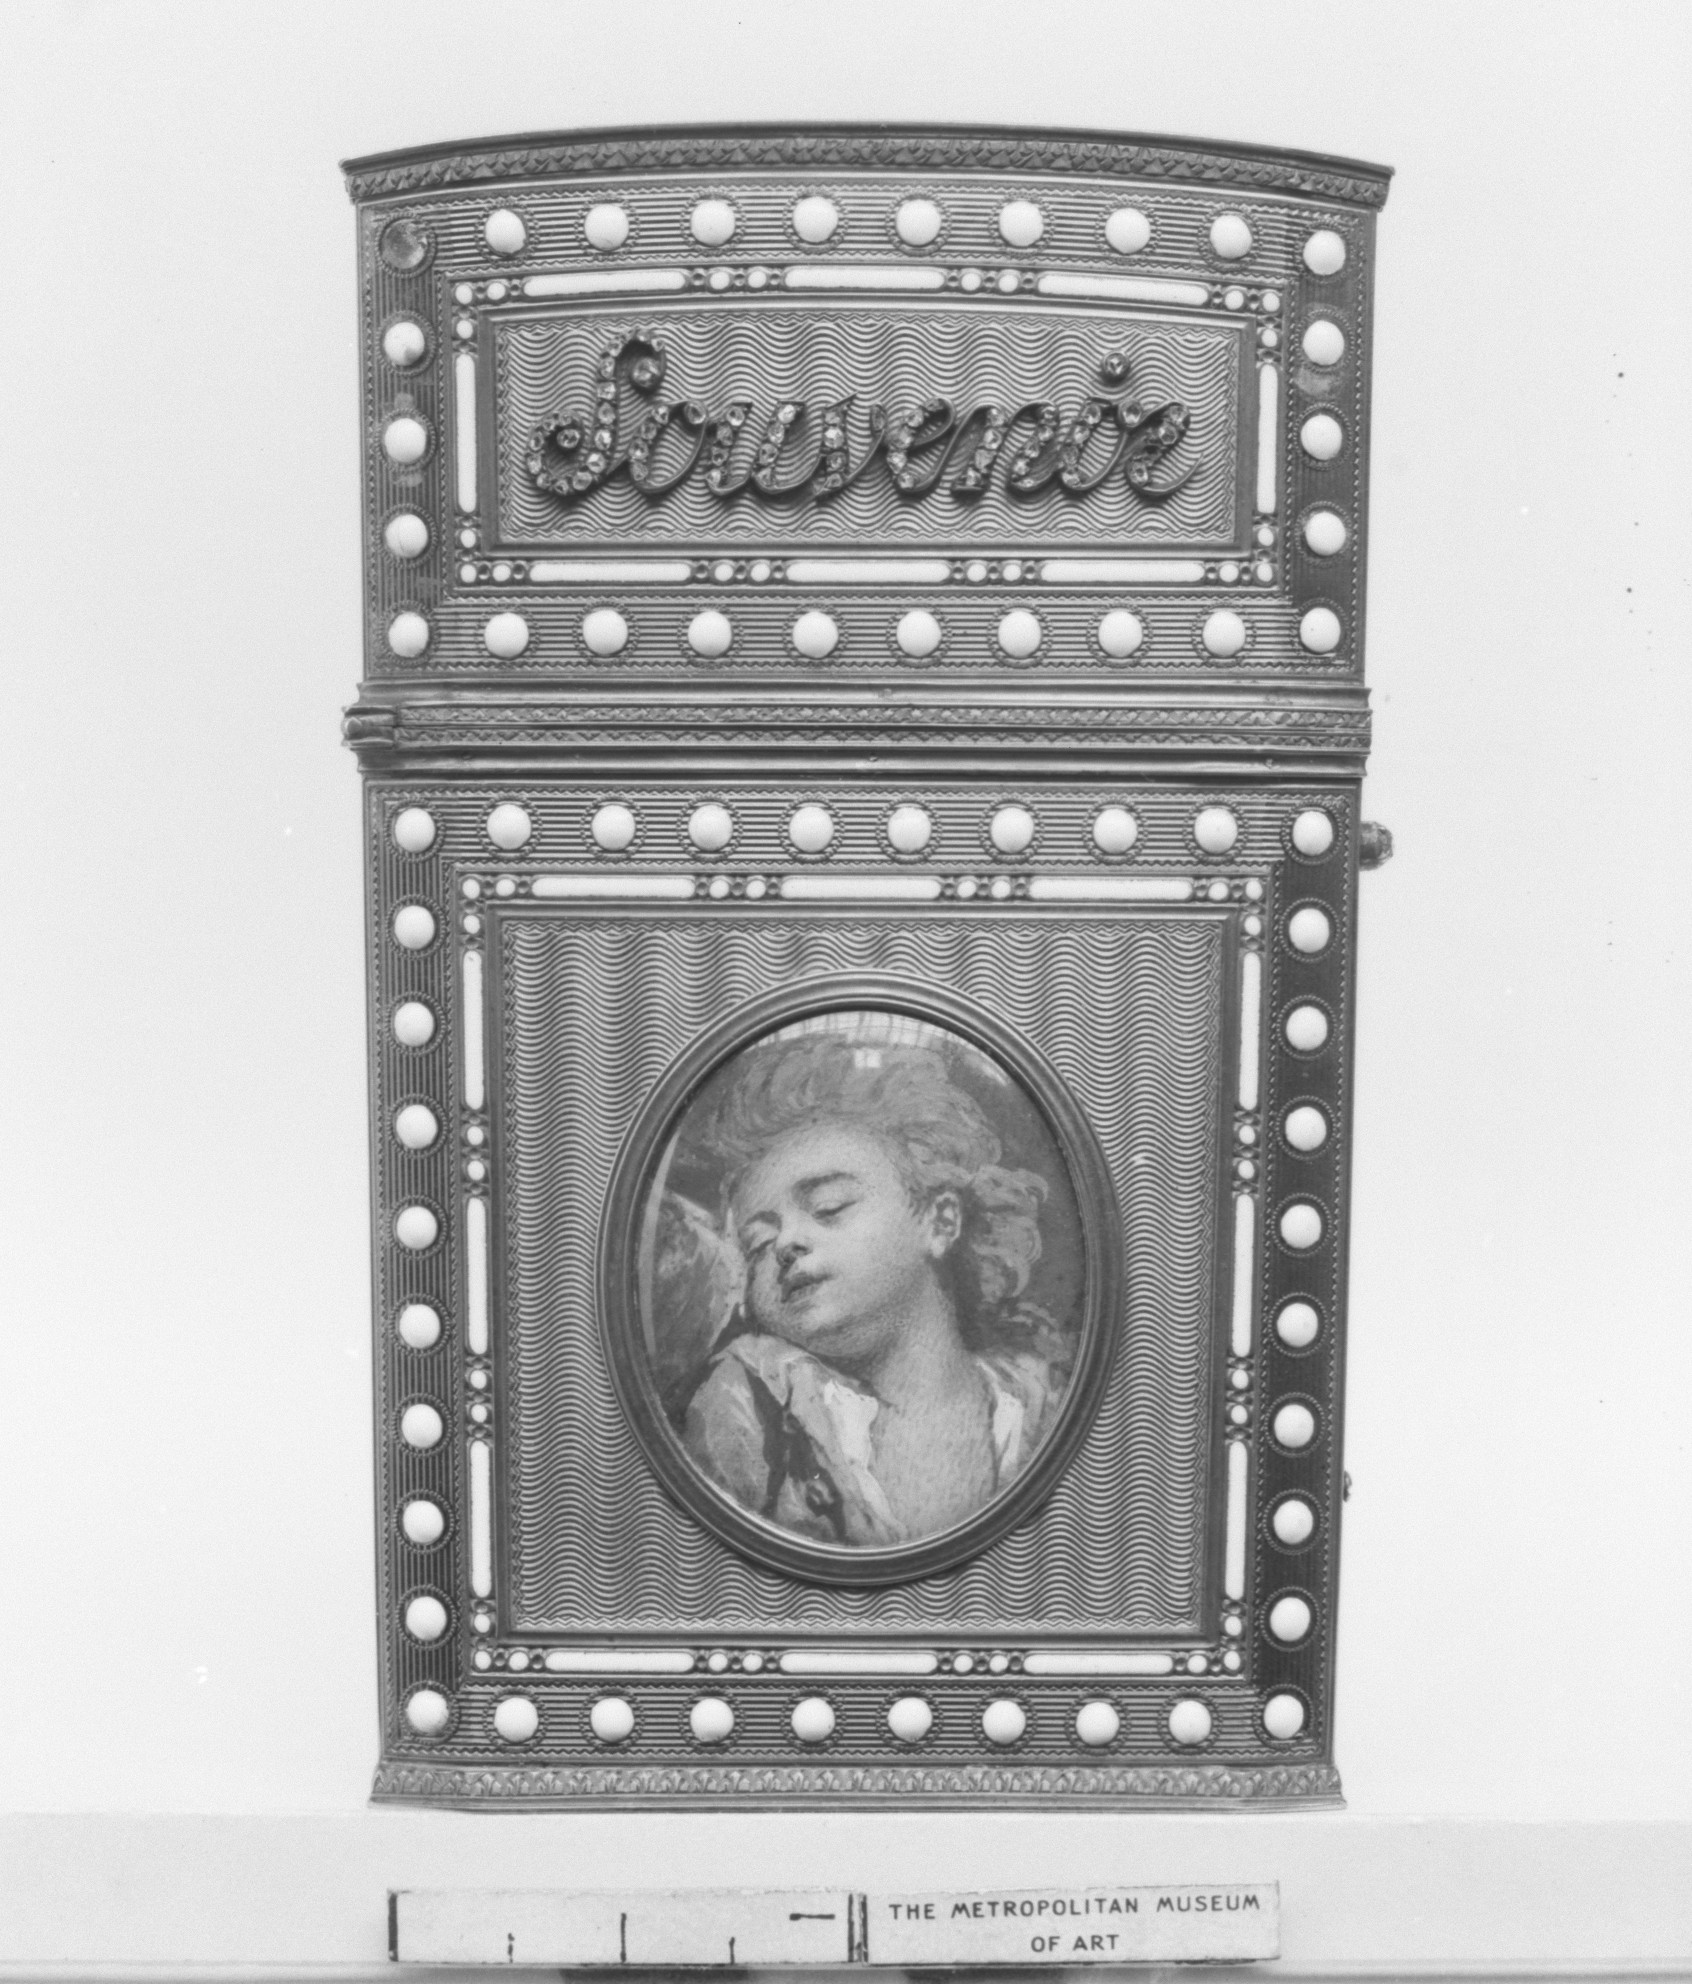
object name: souvenir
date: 1801-1900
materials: diamond, enamel, gold, ivory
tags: girls,portraits